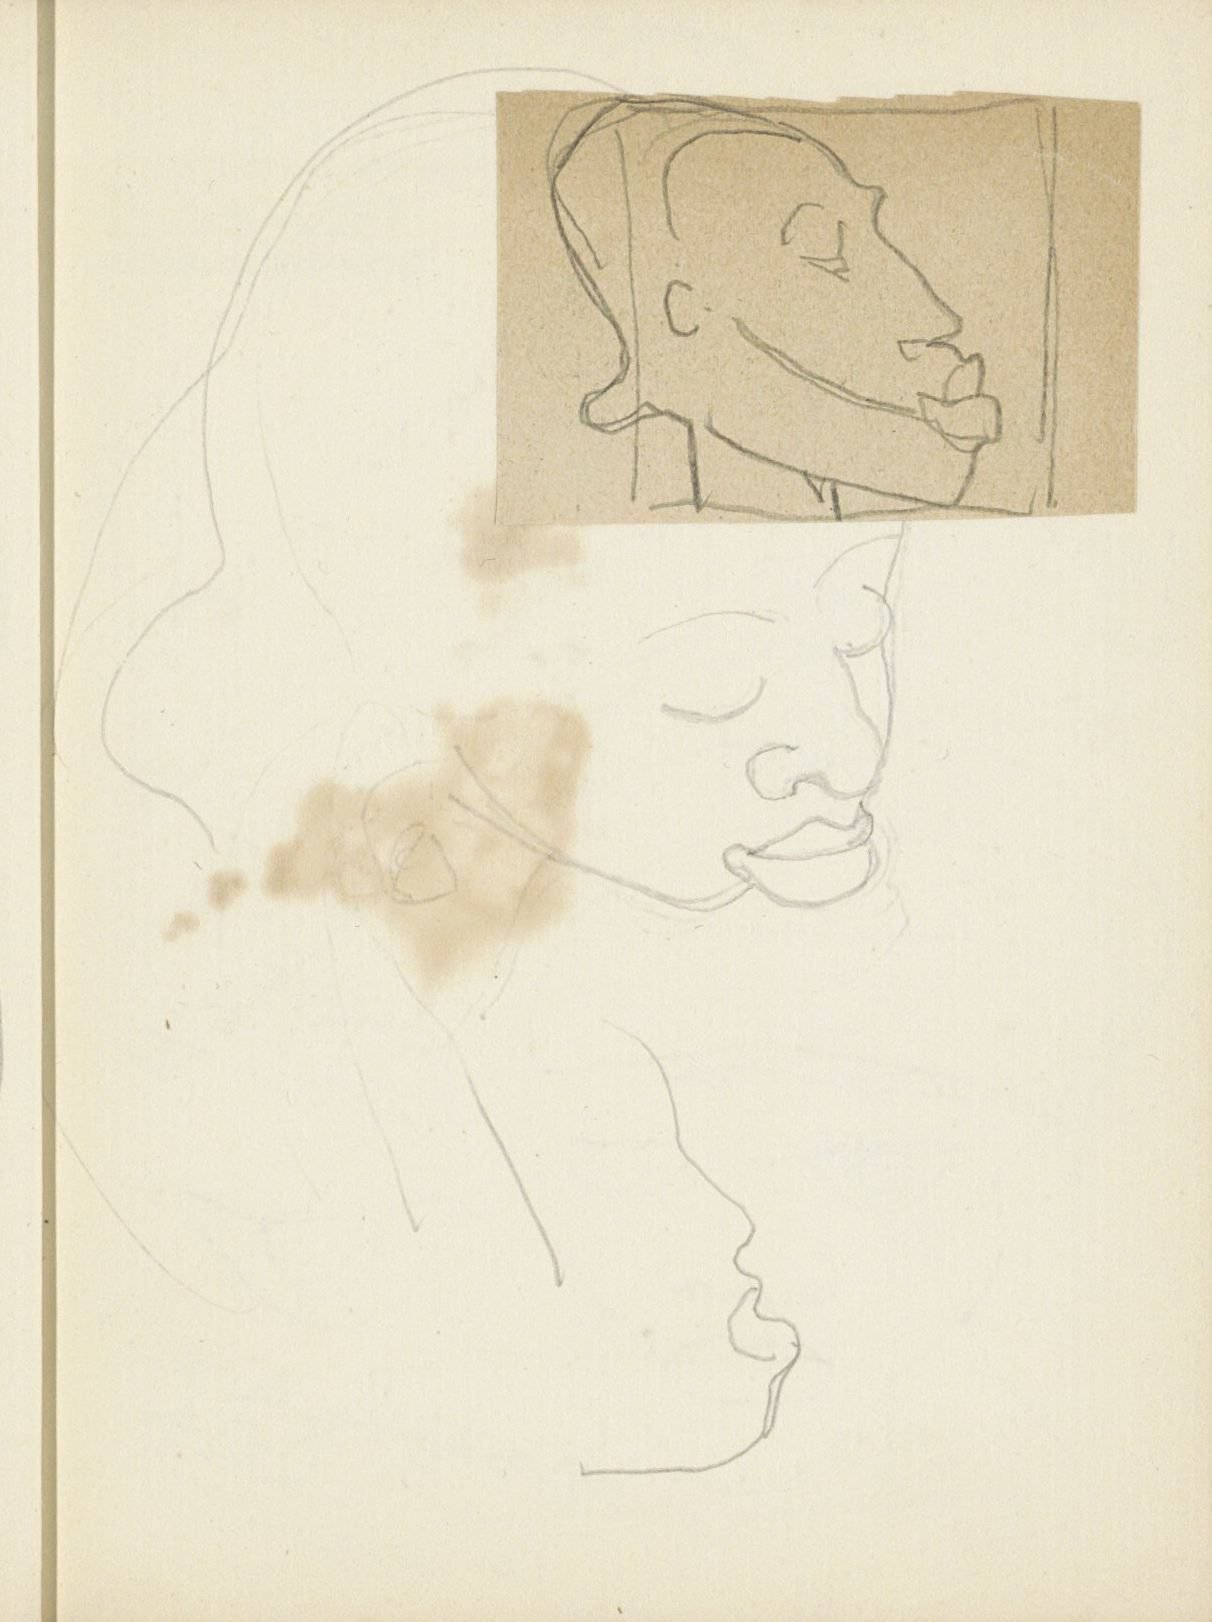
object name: sketchbook leaf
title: Hoofden van Afrikanen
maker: reijer stolk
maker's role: draughtsman, print maker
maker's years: 1896-1945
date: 1916-1945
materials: paper, pencil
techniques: pasting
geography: africa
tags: head (human), africans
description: Blad 22 recto uit een schetsboek met 60 bladen.